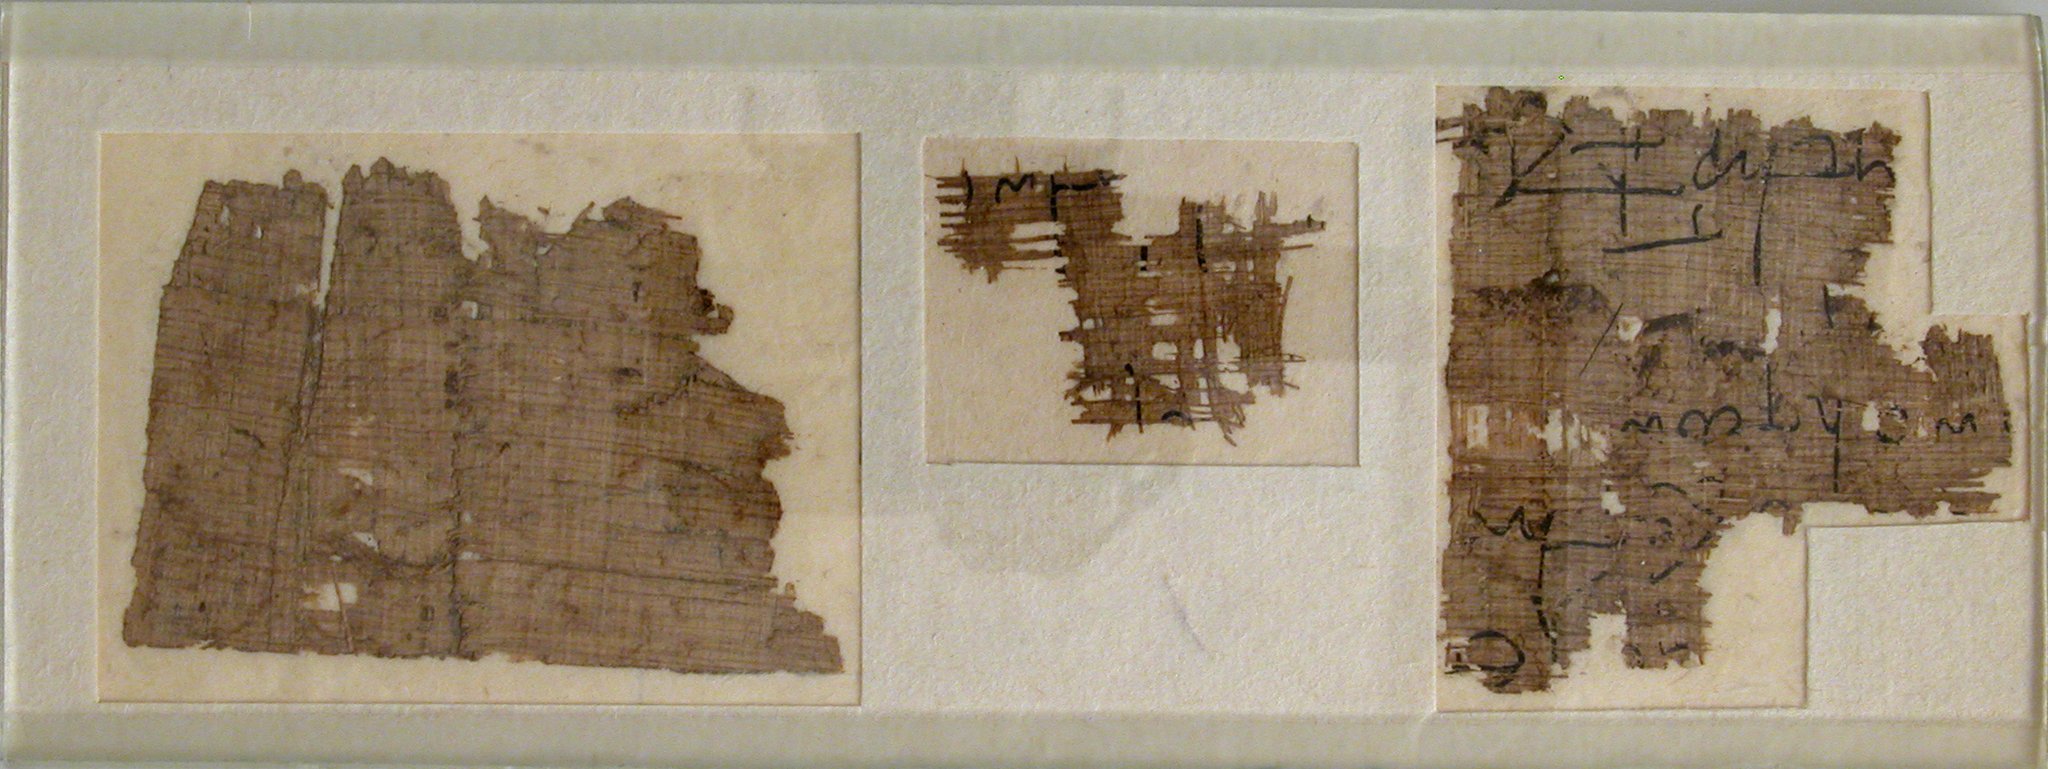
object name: fragment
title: Papyrus fragment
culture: coptic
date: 501-600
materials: ink, papyrus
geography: egypt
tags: documents,greek